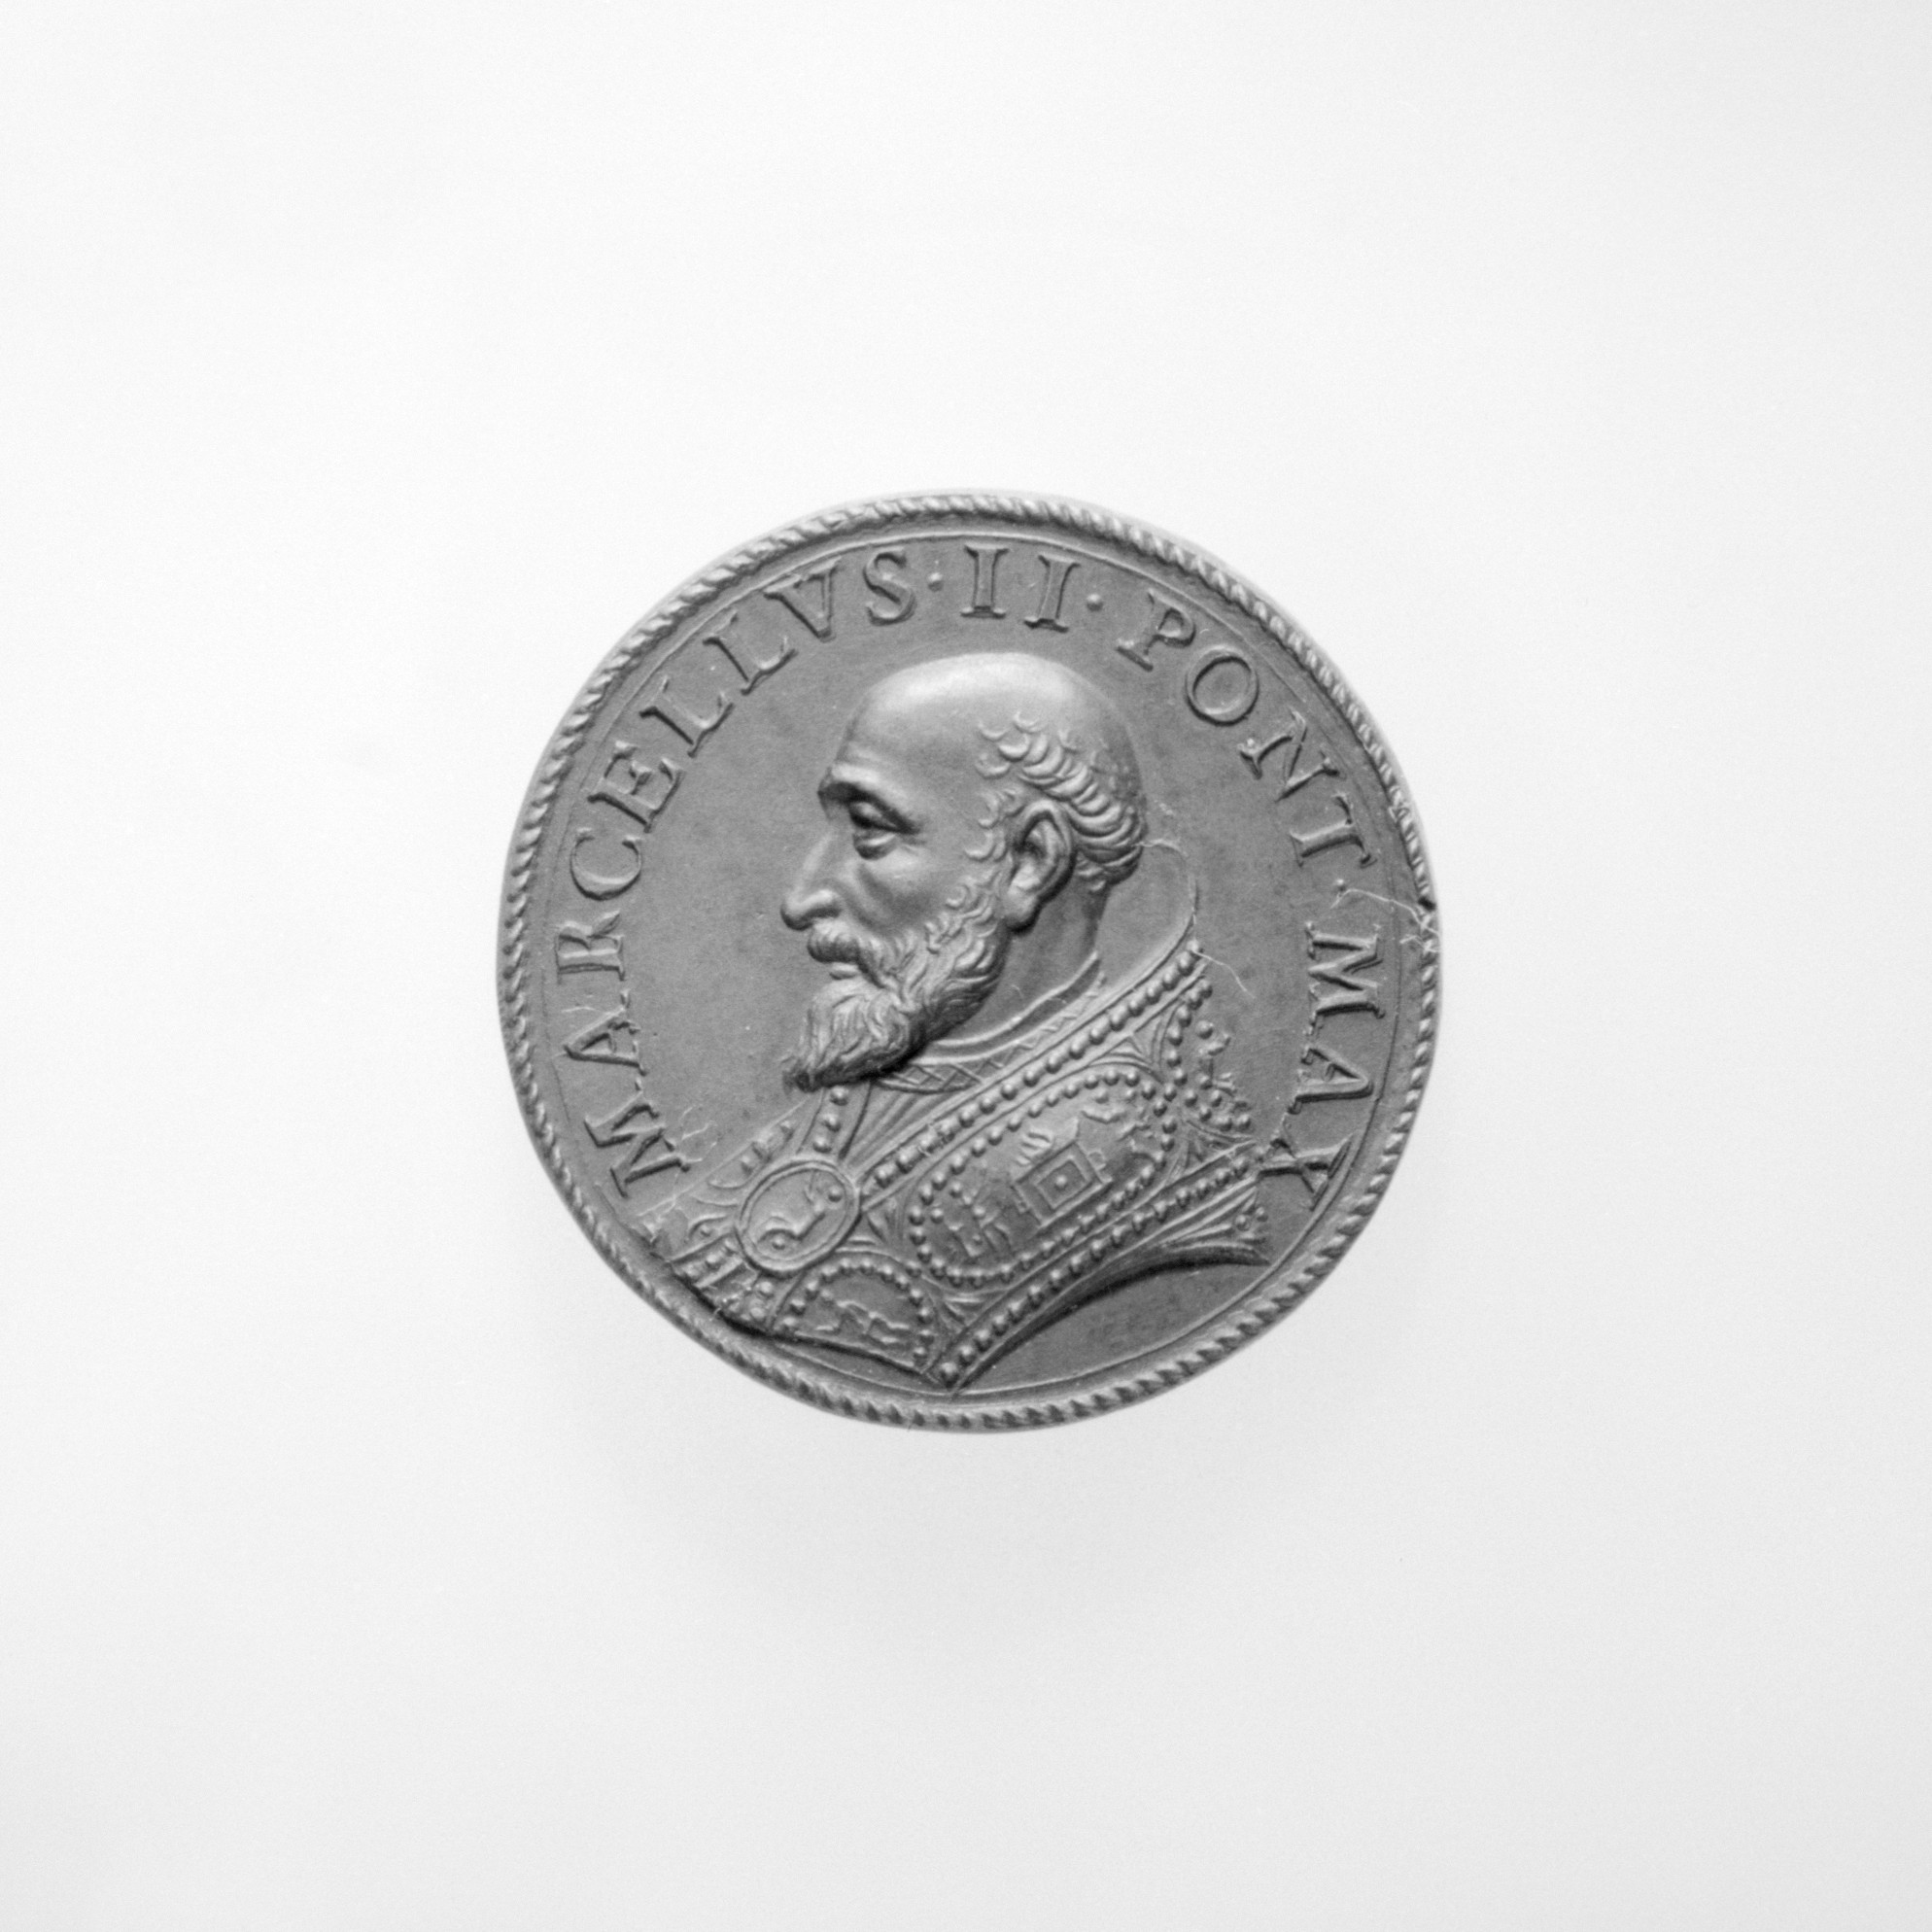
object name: medal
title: Pope Marcellus II (1555)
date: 1501-1600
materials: bronze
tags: profiles,popes